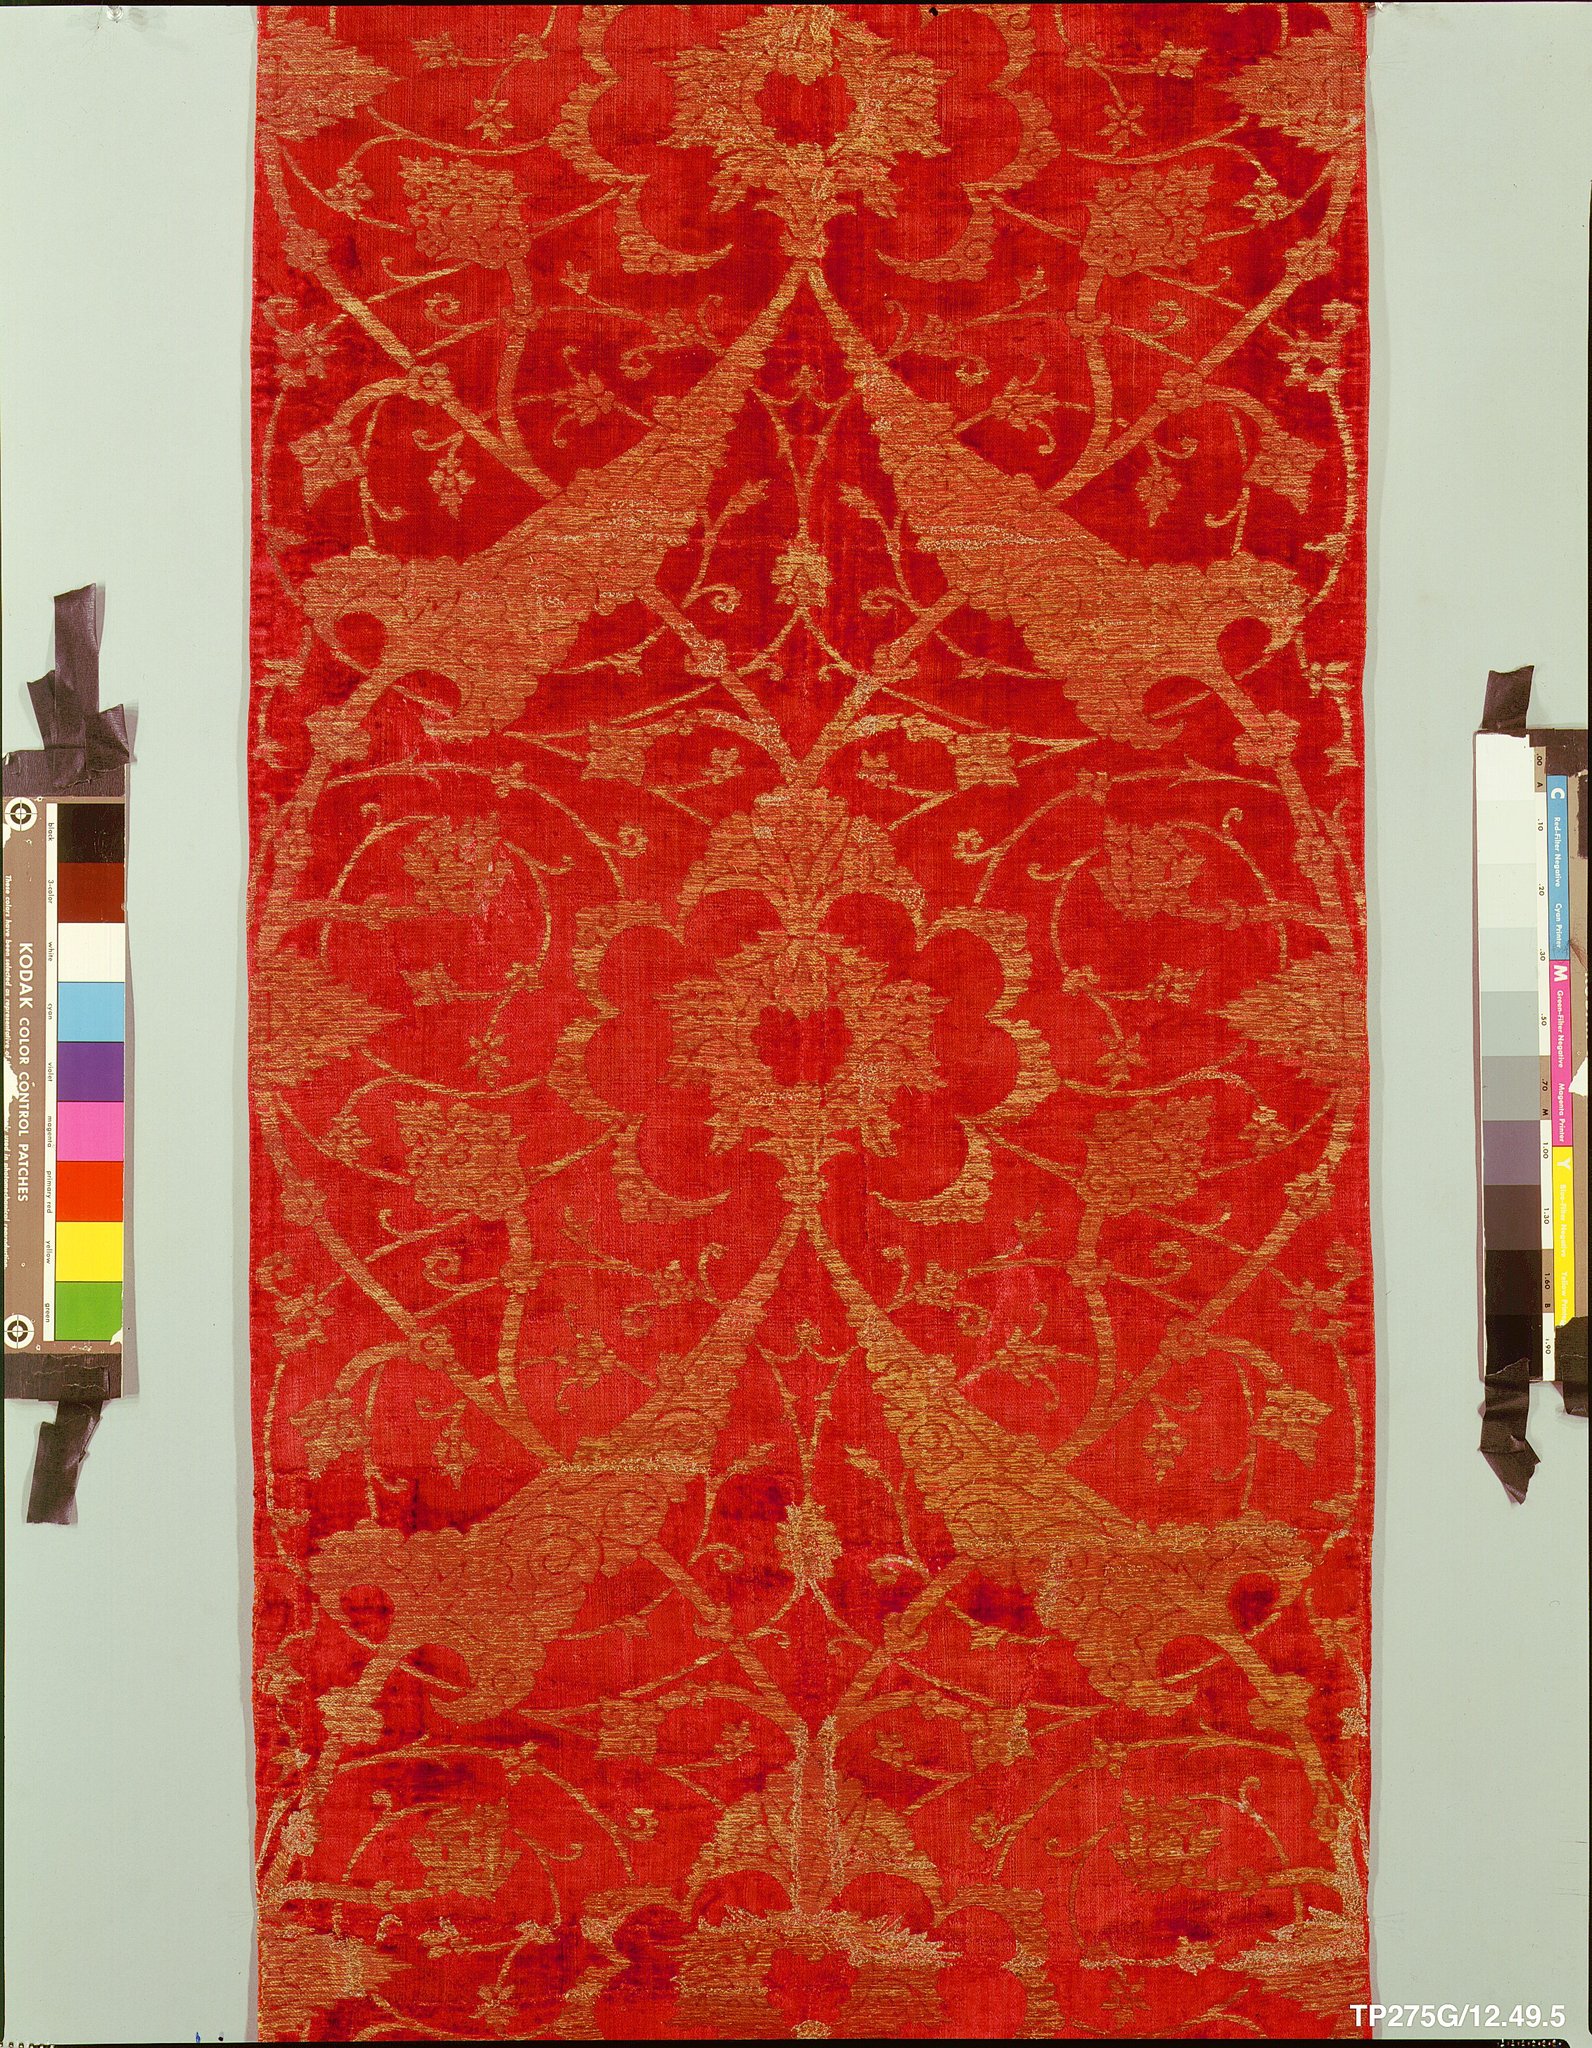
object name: piece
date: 1467-1500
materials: metal thread, silk